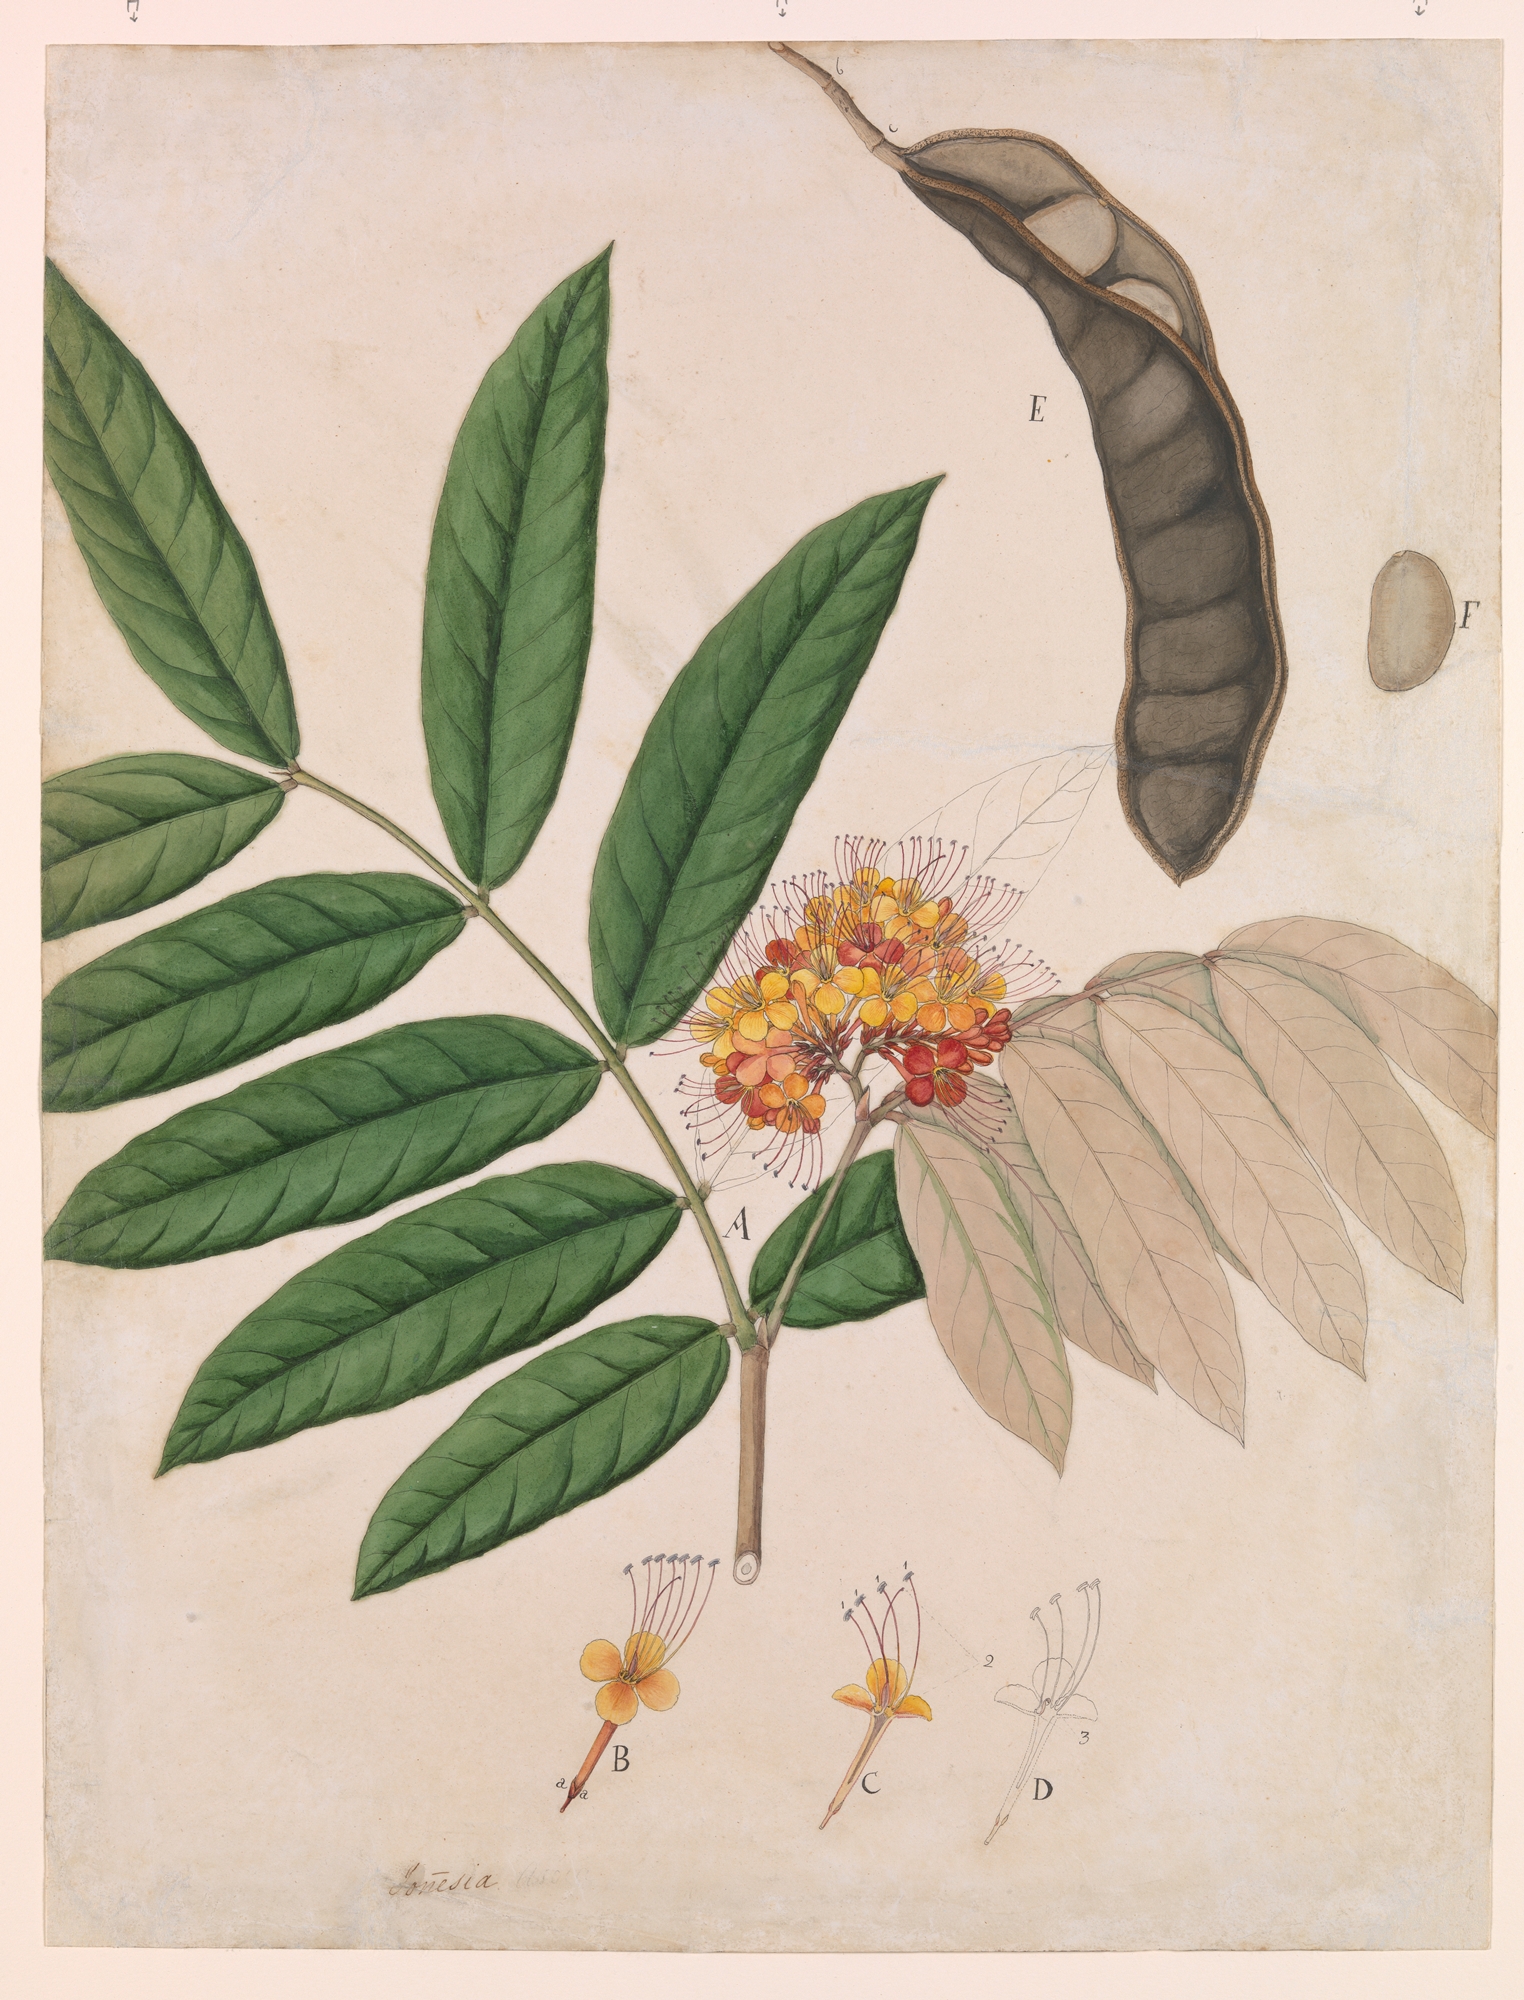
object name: illustrated single work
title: Ashoka Tree Flower, Leaves, Pod, and Seed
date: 1801-1850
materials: paper, watercolor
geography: india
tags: flowers,leaves